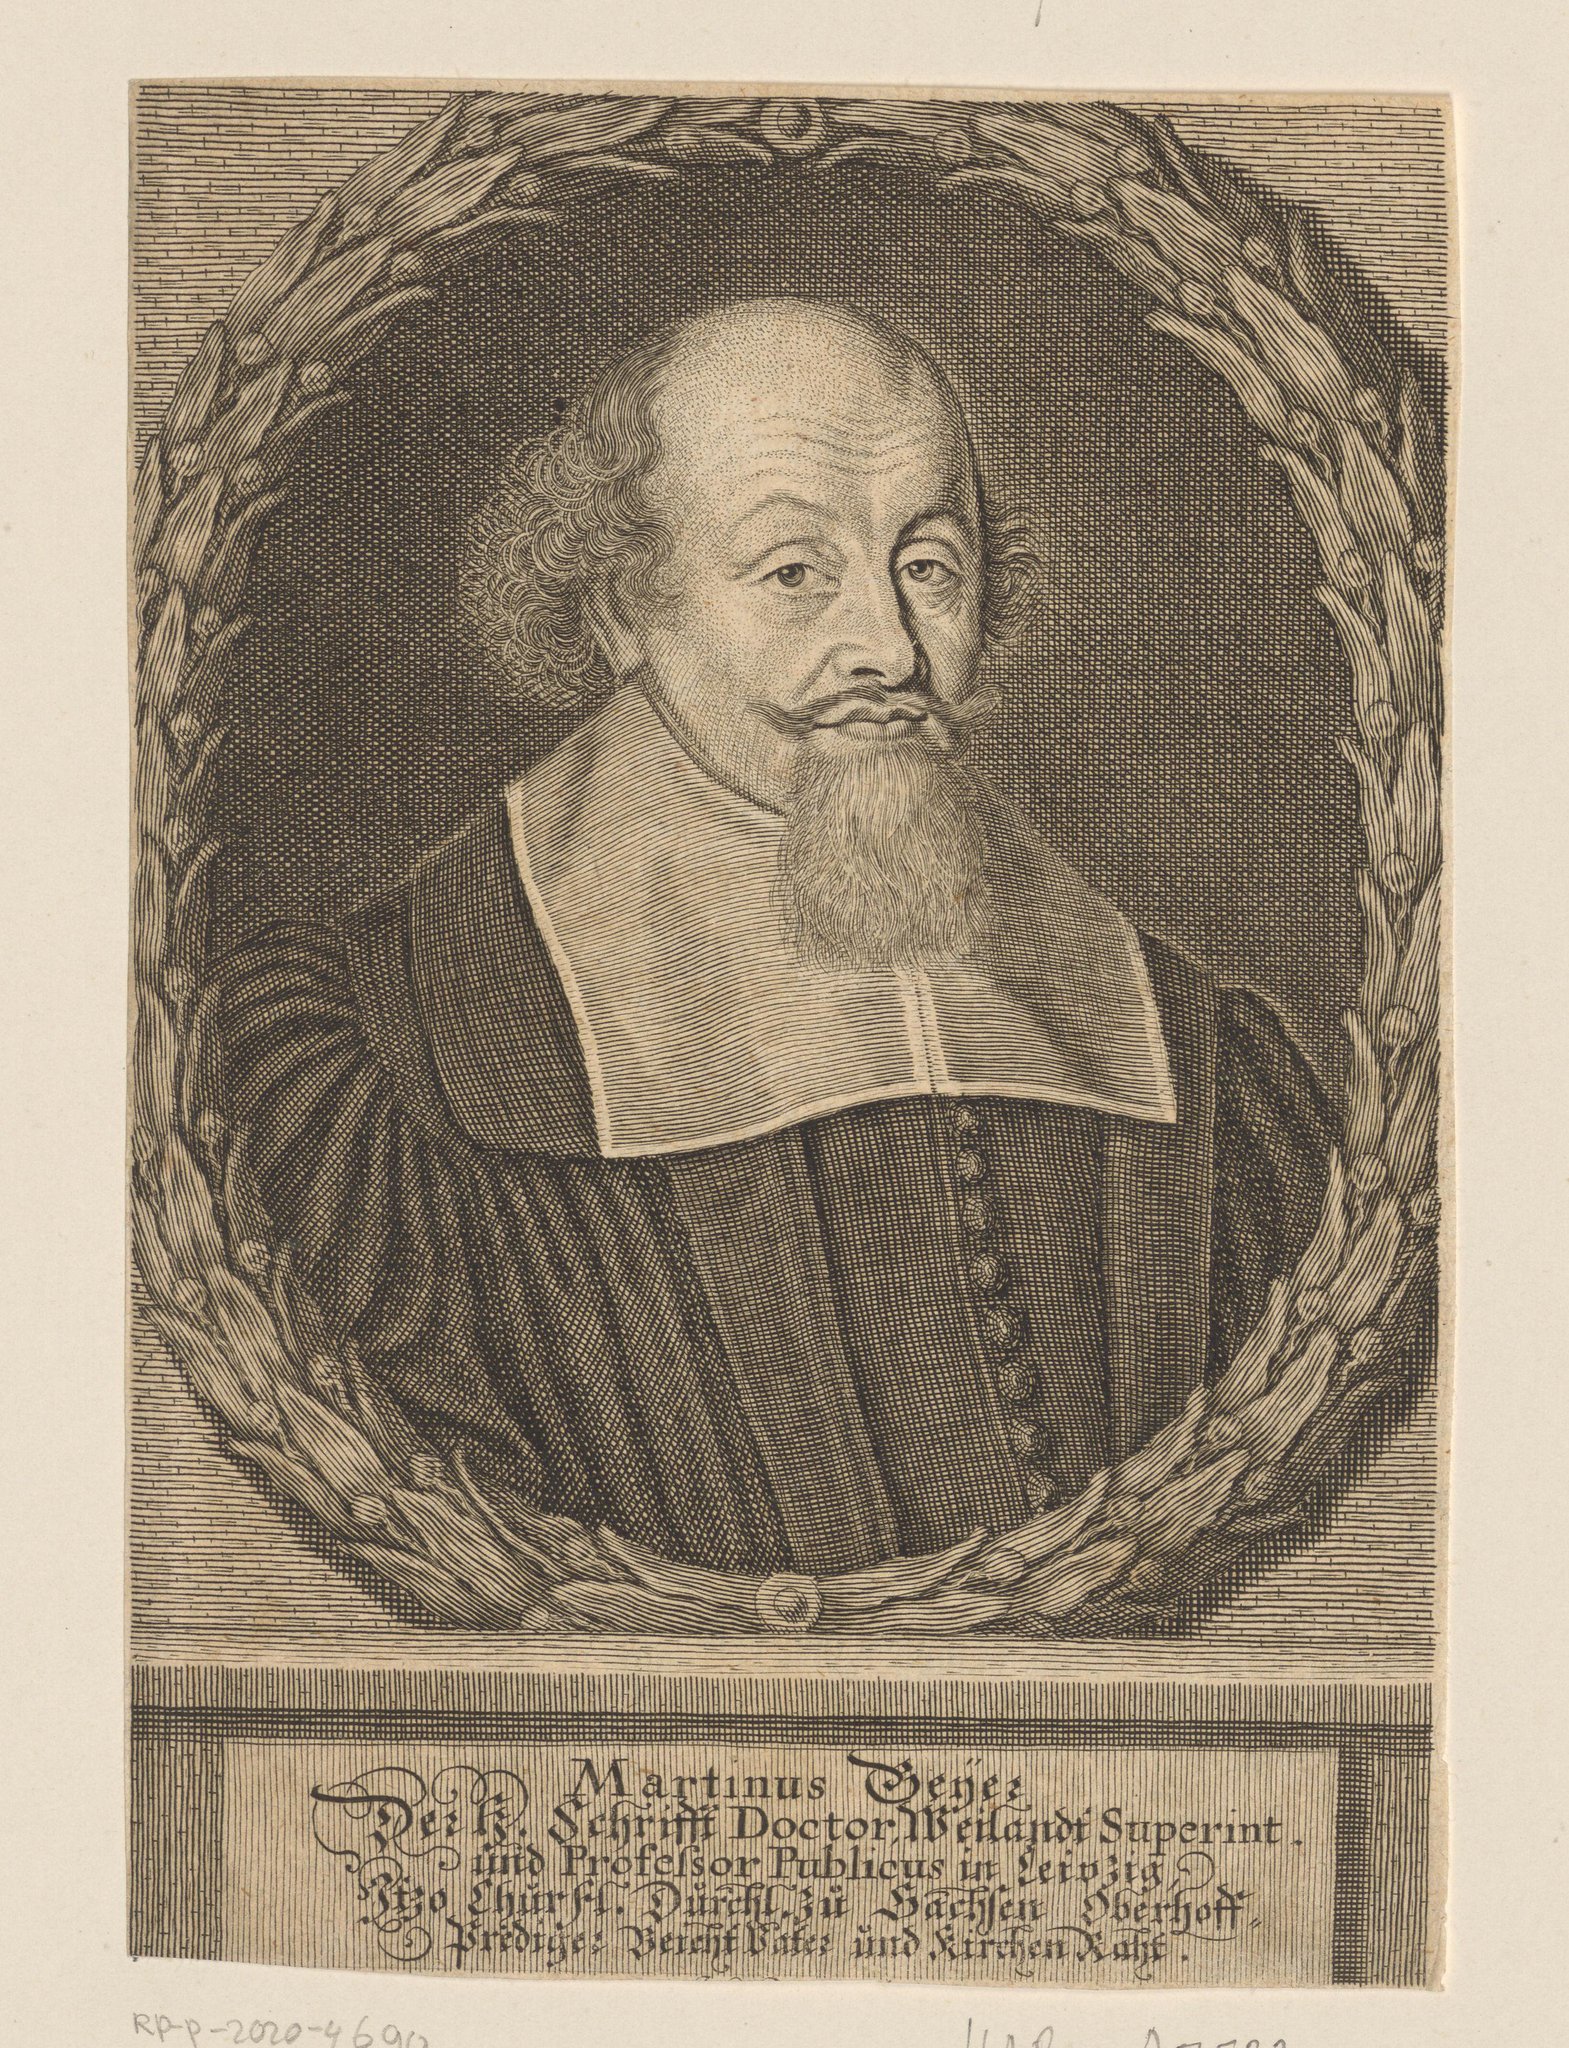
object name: print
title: Portret van Martin Geier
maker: jakob von sandrart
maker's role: print maker, publisher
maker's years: 1630-1708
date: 1650-1708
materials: paper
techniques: engraving, etching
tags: theologian, historical persons, writer, poet, author